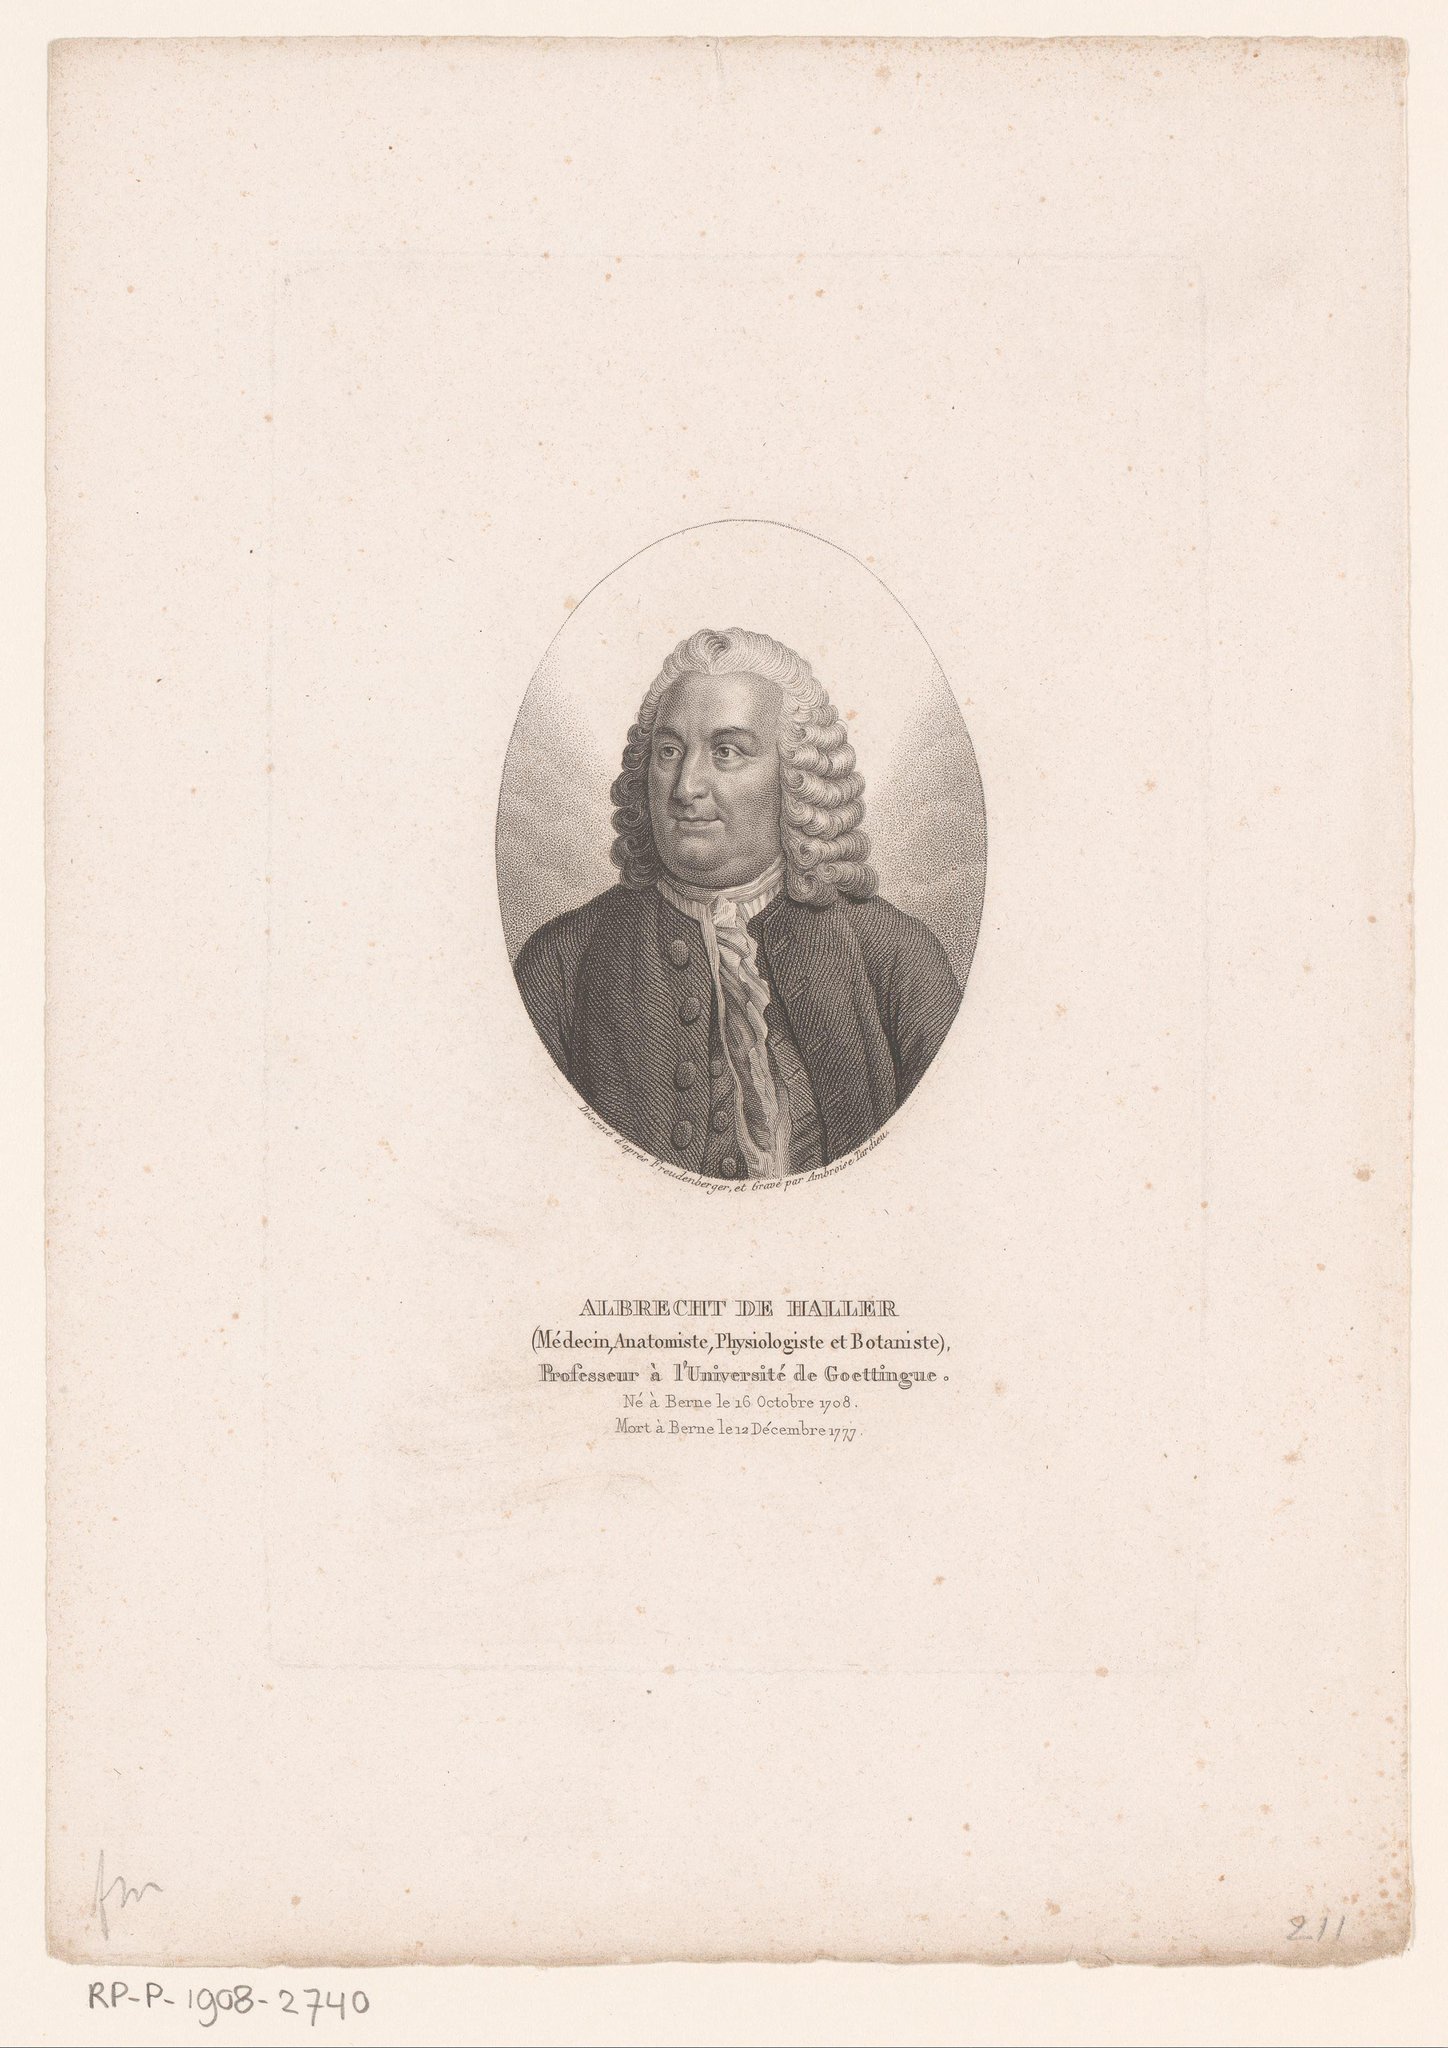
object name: print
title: Portret van Albrecht Haller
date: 1820-1828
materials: paper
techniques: engraving, roulette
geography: paris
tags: physicist, historical persons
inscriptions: collector's mark: Lugt 2228